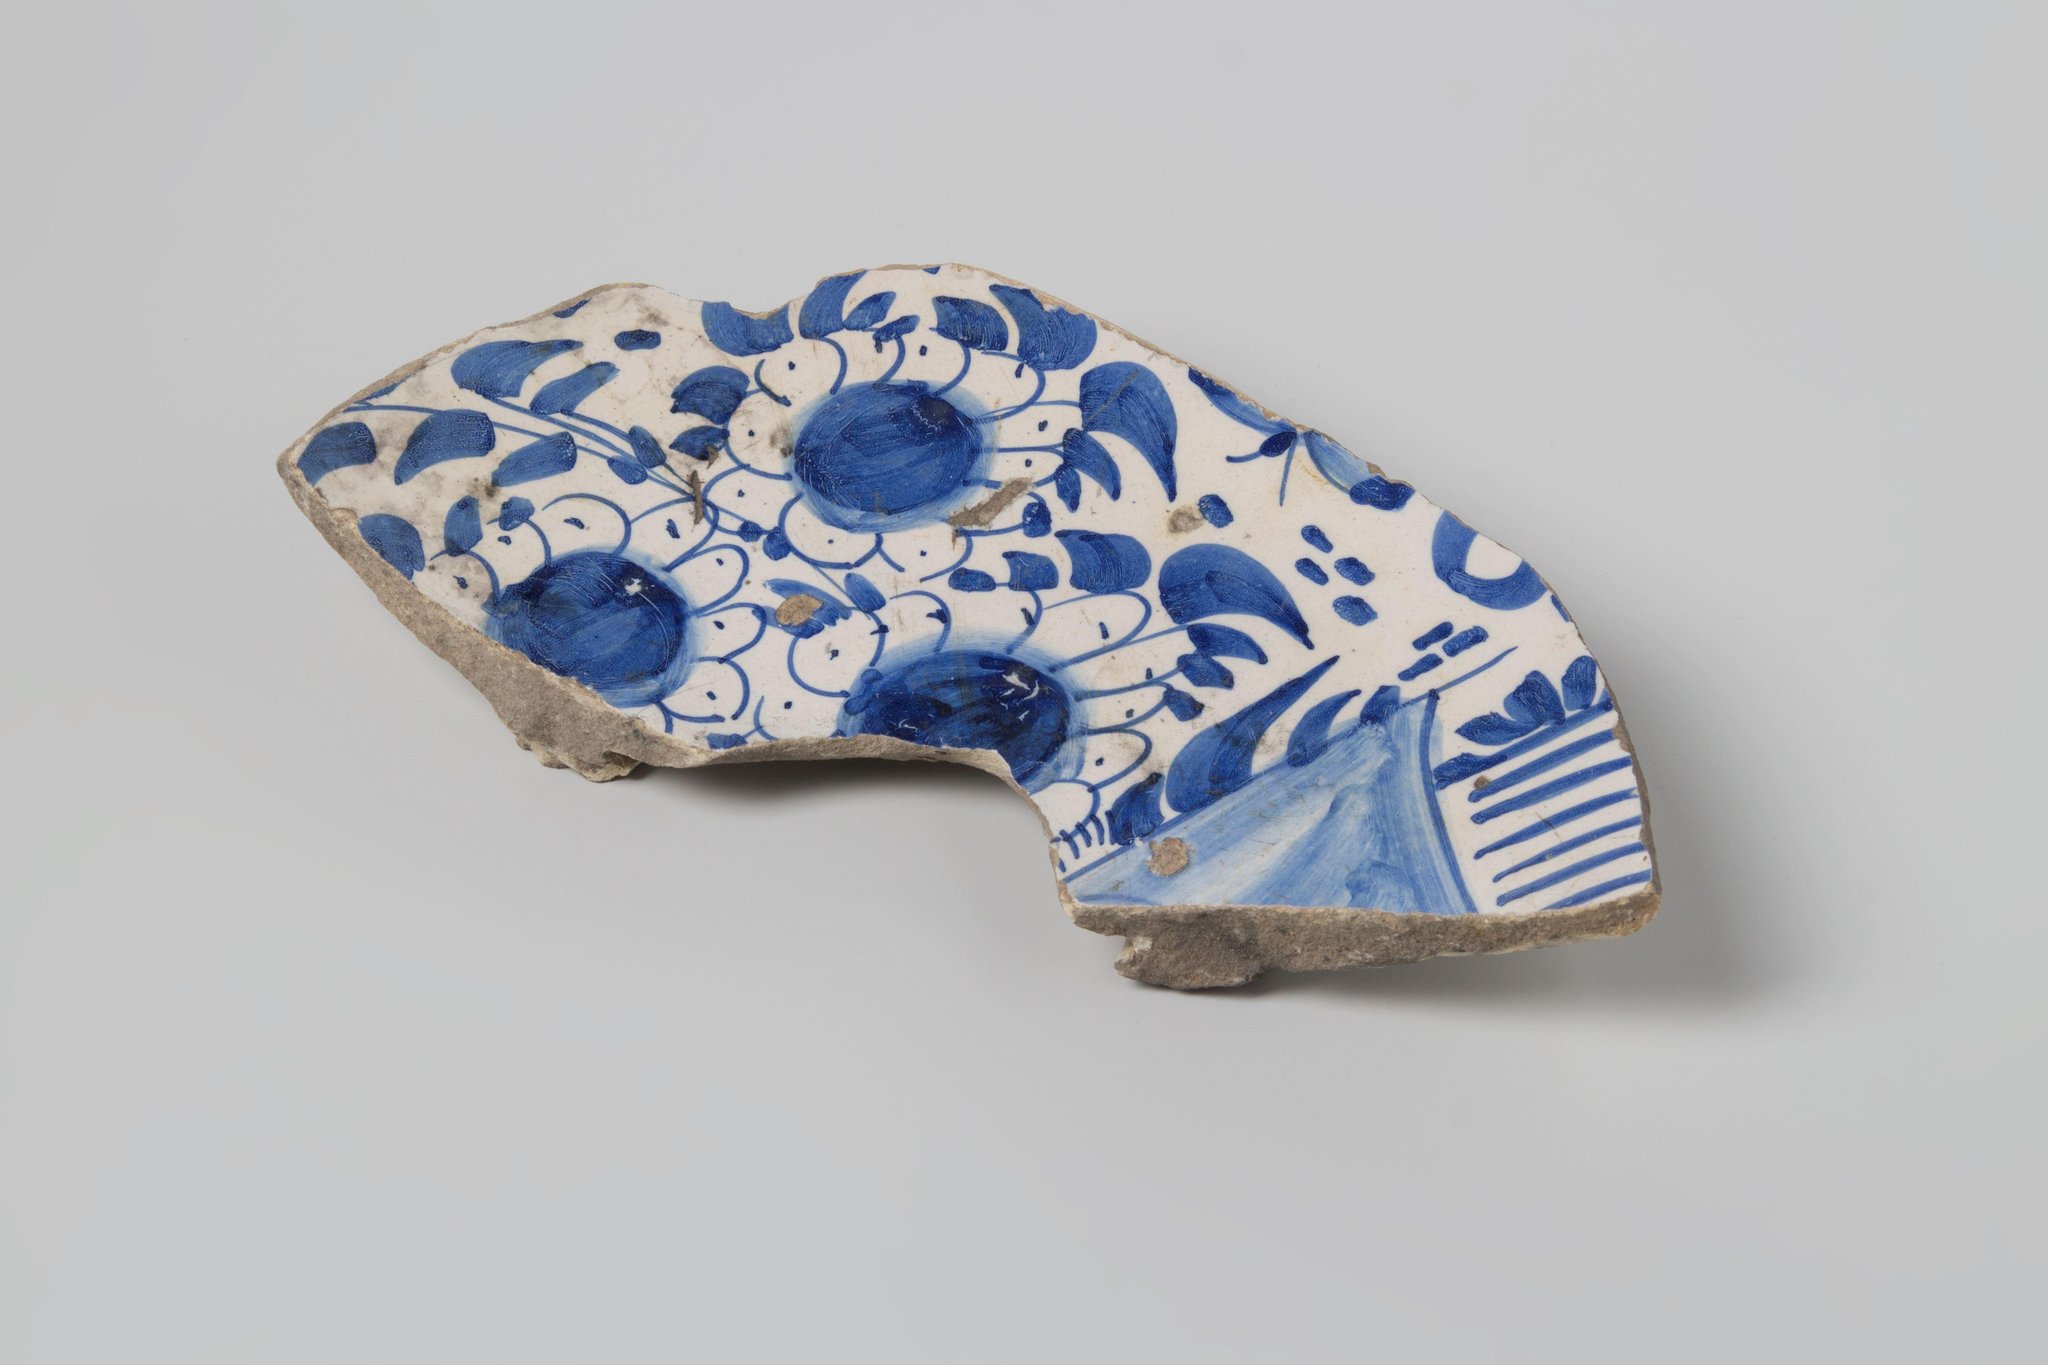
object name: sherd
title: Schotelscherf van aardewerk met aan de achterzijde loodglazuur en aan de voorzijde tinglazuur en een decoratie van bloemen in blauw, beschadigd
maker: Anonymous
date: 1500-1799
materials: earthenware, glaze